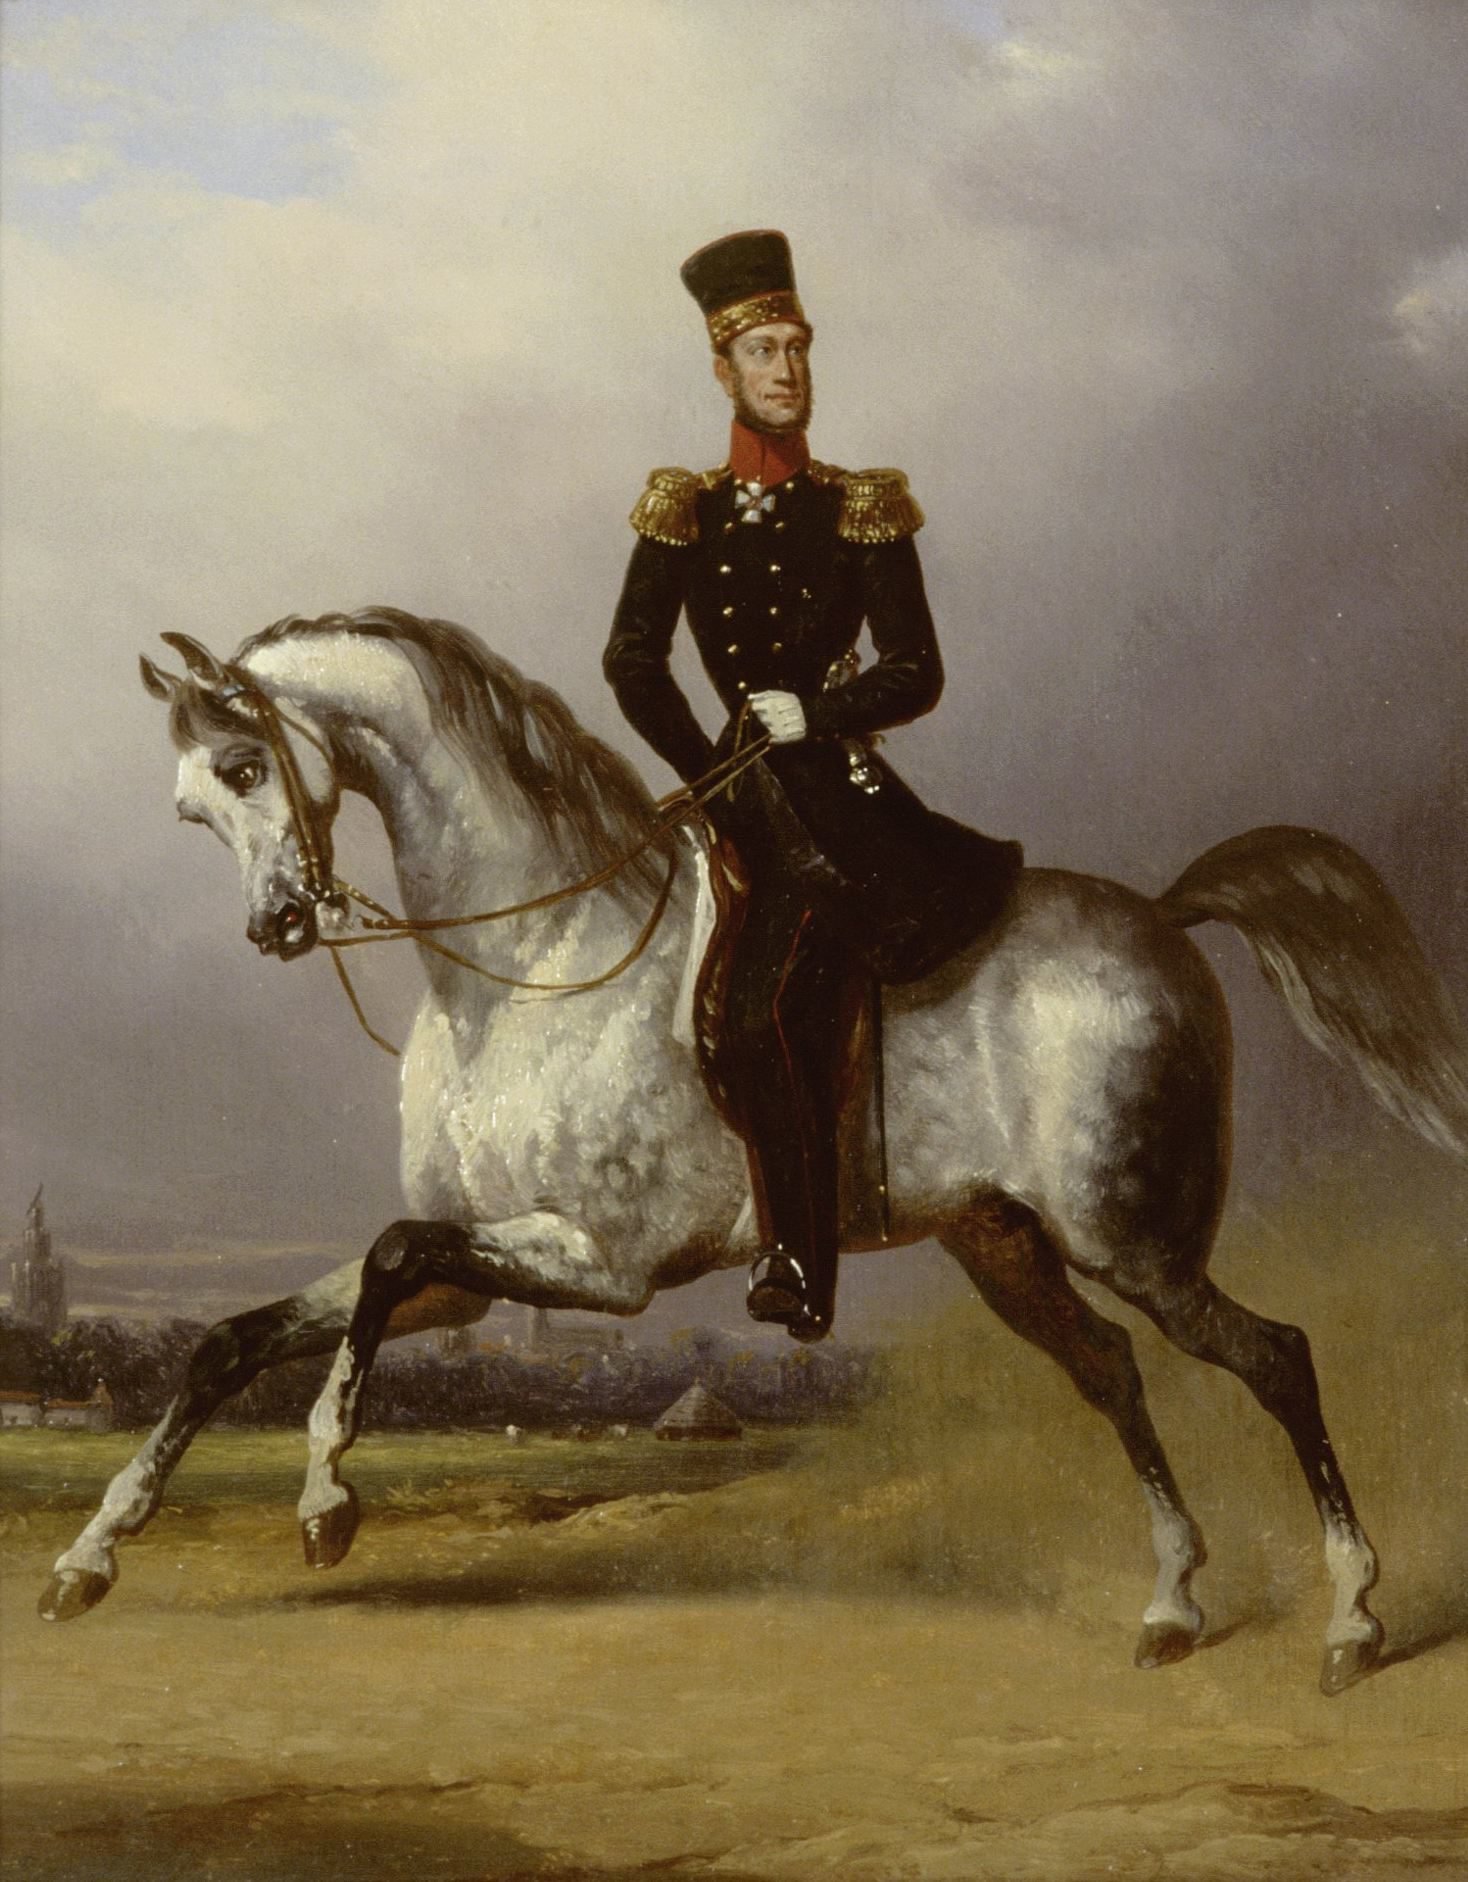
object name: painting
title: Equestrian Portrait of William II, King of the Netherlands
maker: nicolaas pieneman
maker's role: draughtsman, painter, print maker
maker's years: 1809-1860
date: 1830-1850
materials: oil, panel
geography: netherlands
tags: the hague, william ii of the netherlands, equestrian state-portrait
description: Portret van Willem II (1792-1849), koning der Nederlanden, op een springend paard, naar links.